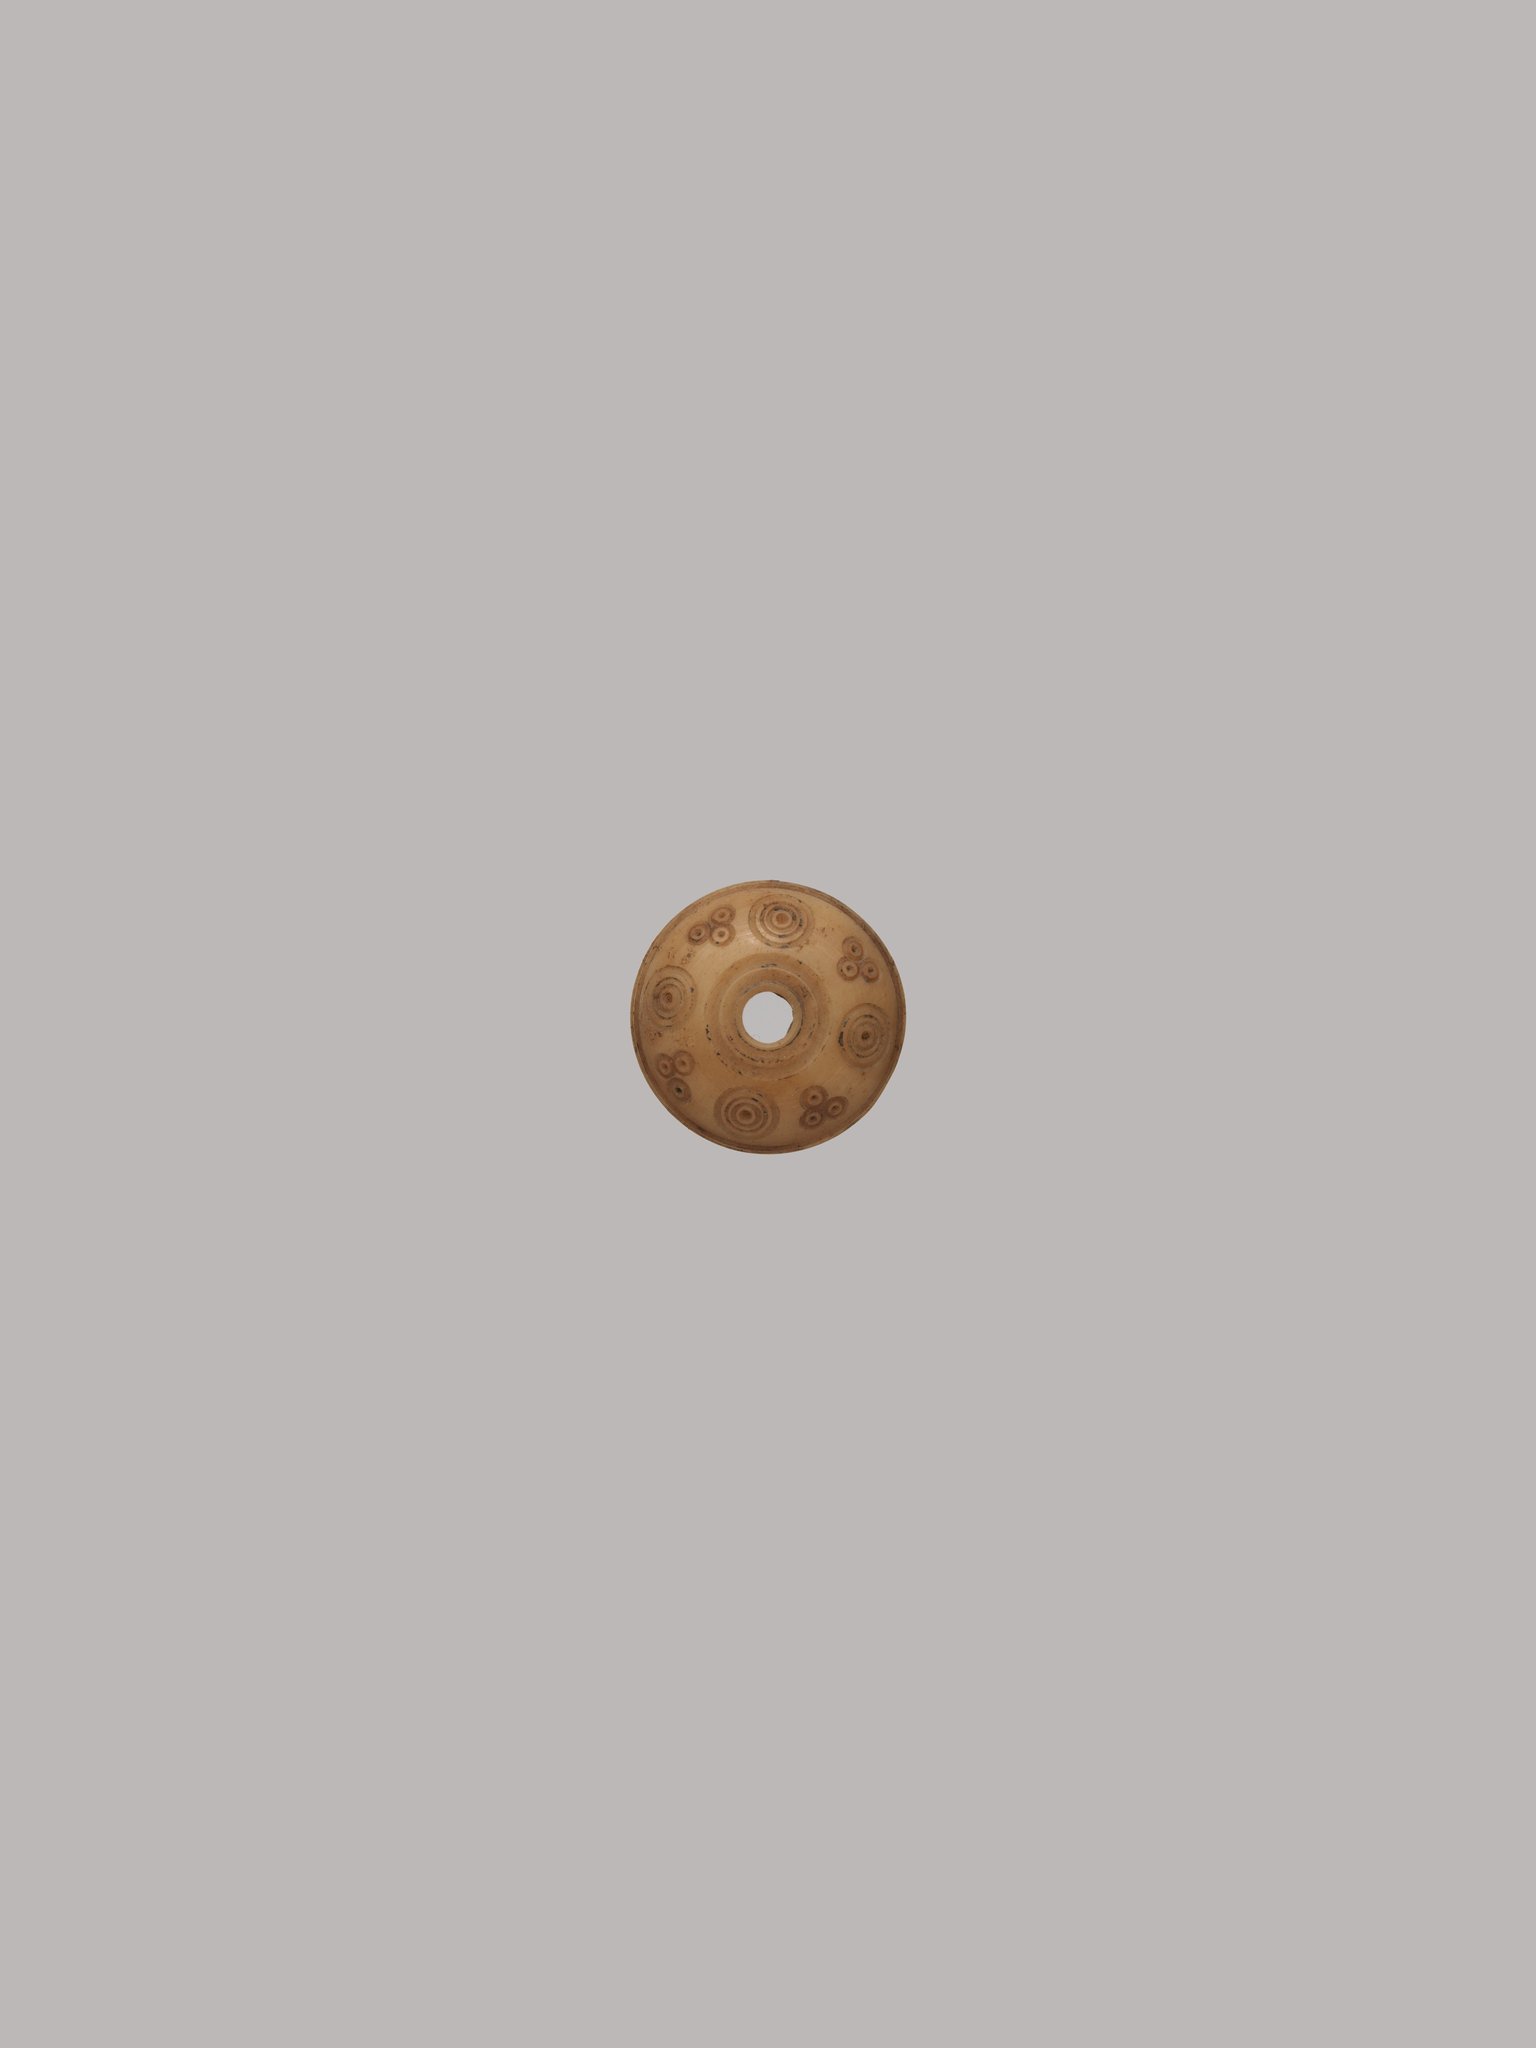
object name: button or bead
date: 801-1000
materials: bone, paint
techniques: incising, inlay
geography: iran